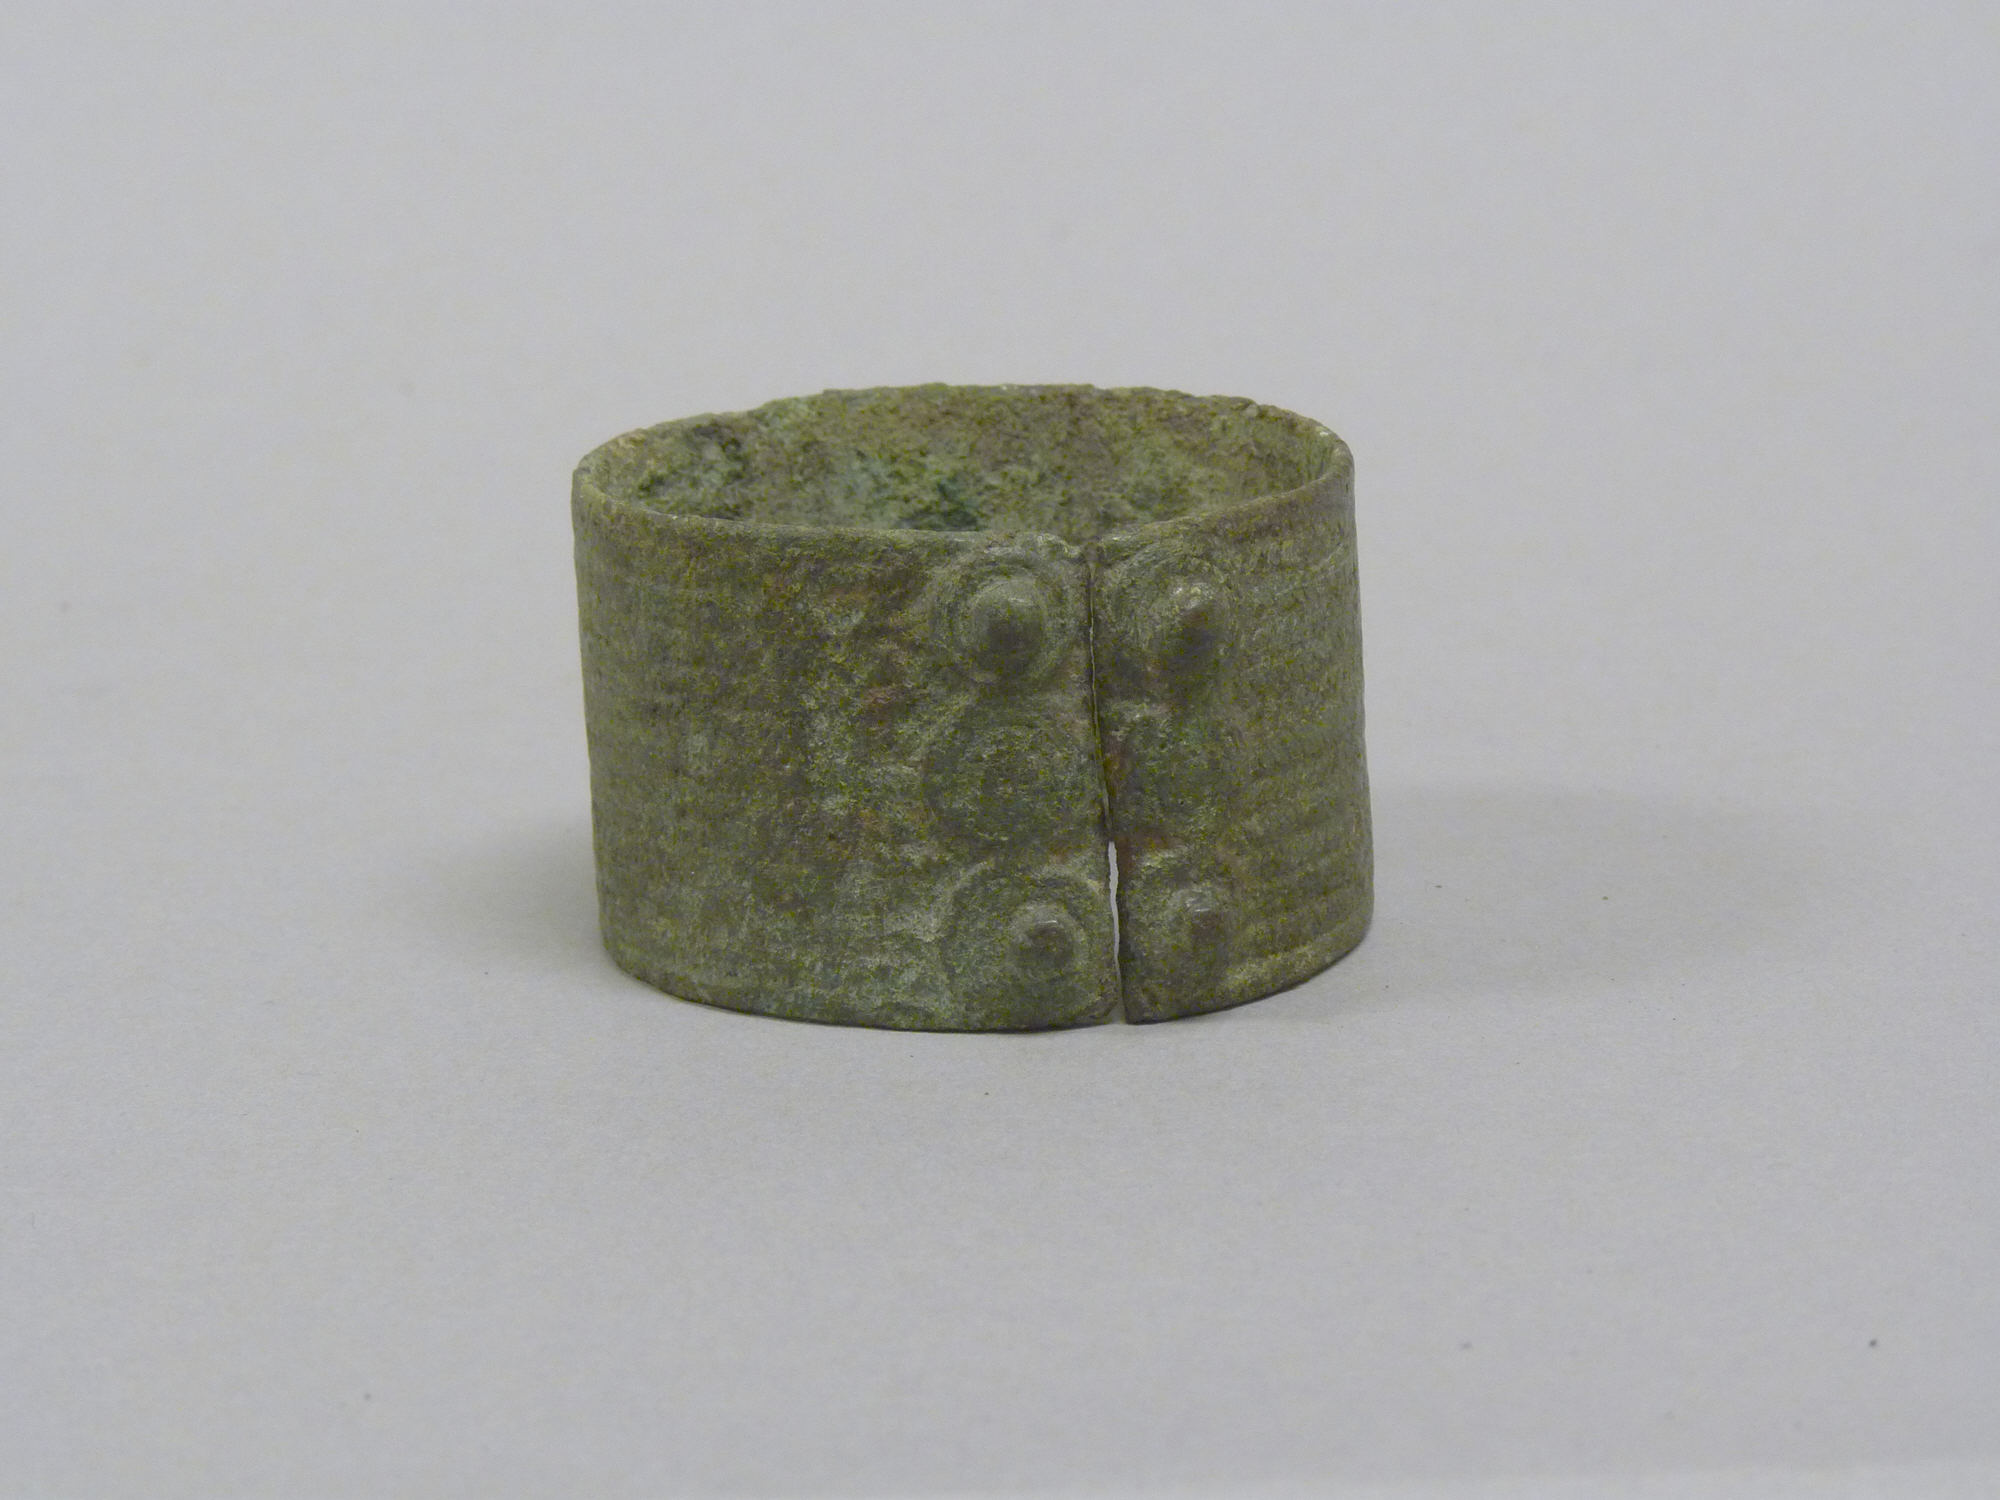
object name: bracelet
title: Open Wide Bracelet with Striations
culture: thai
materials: bronze